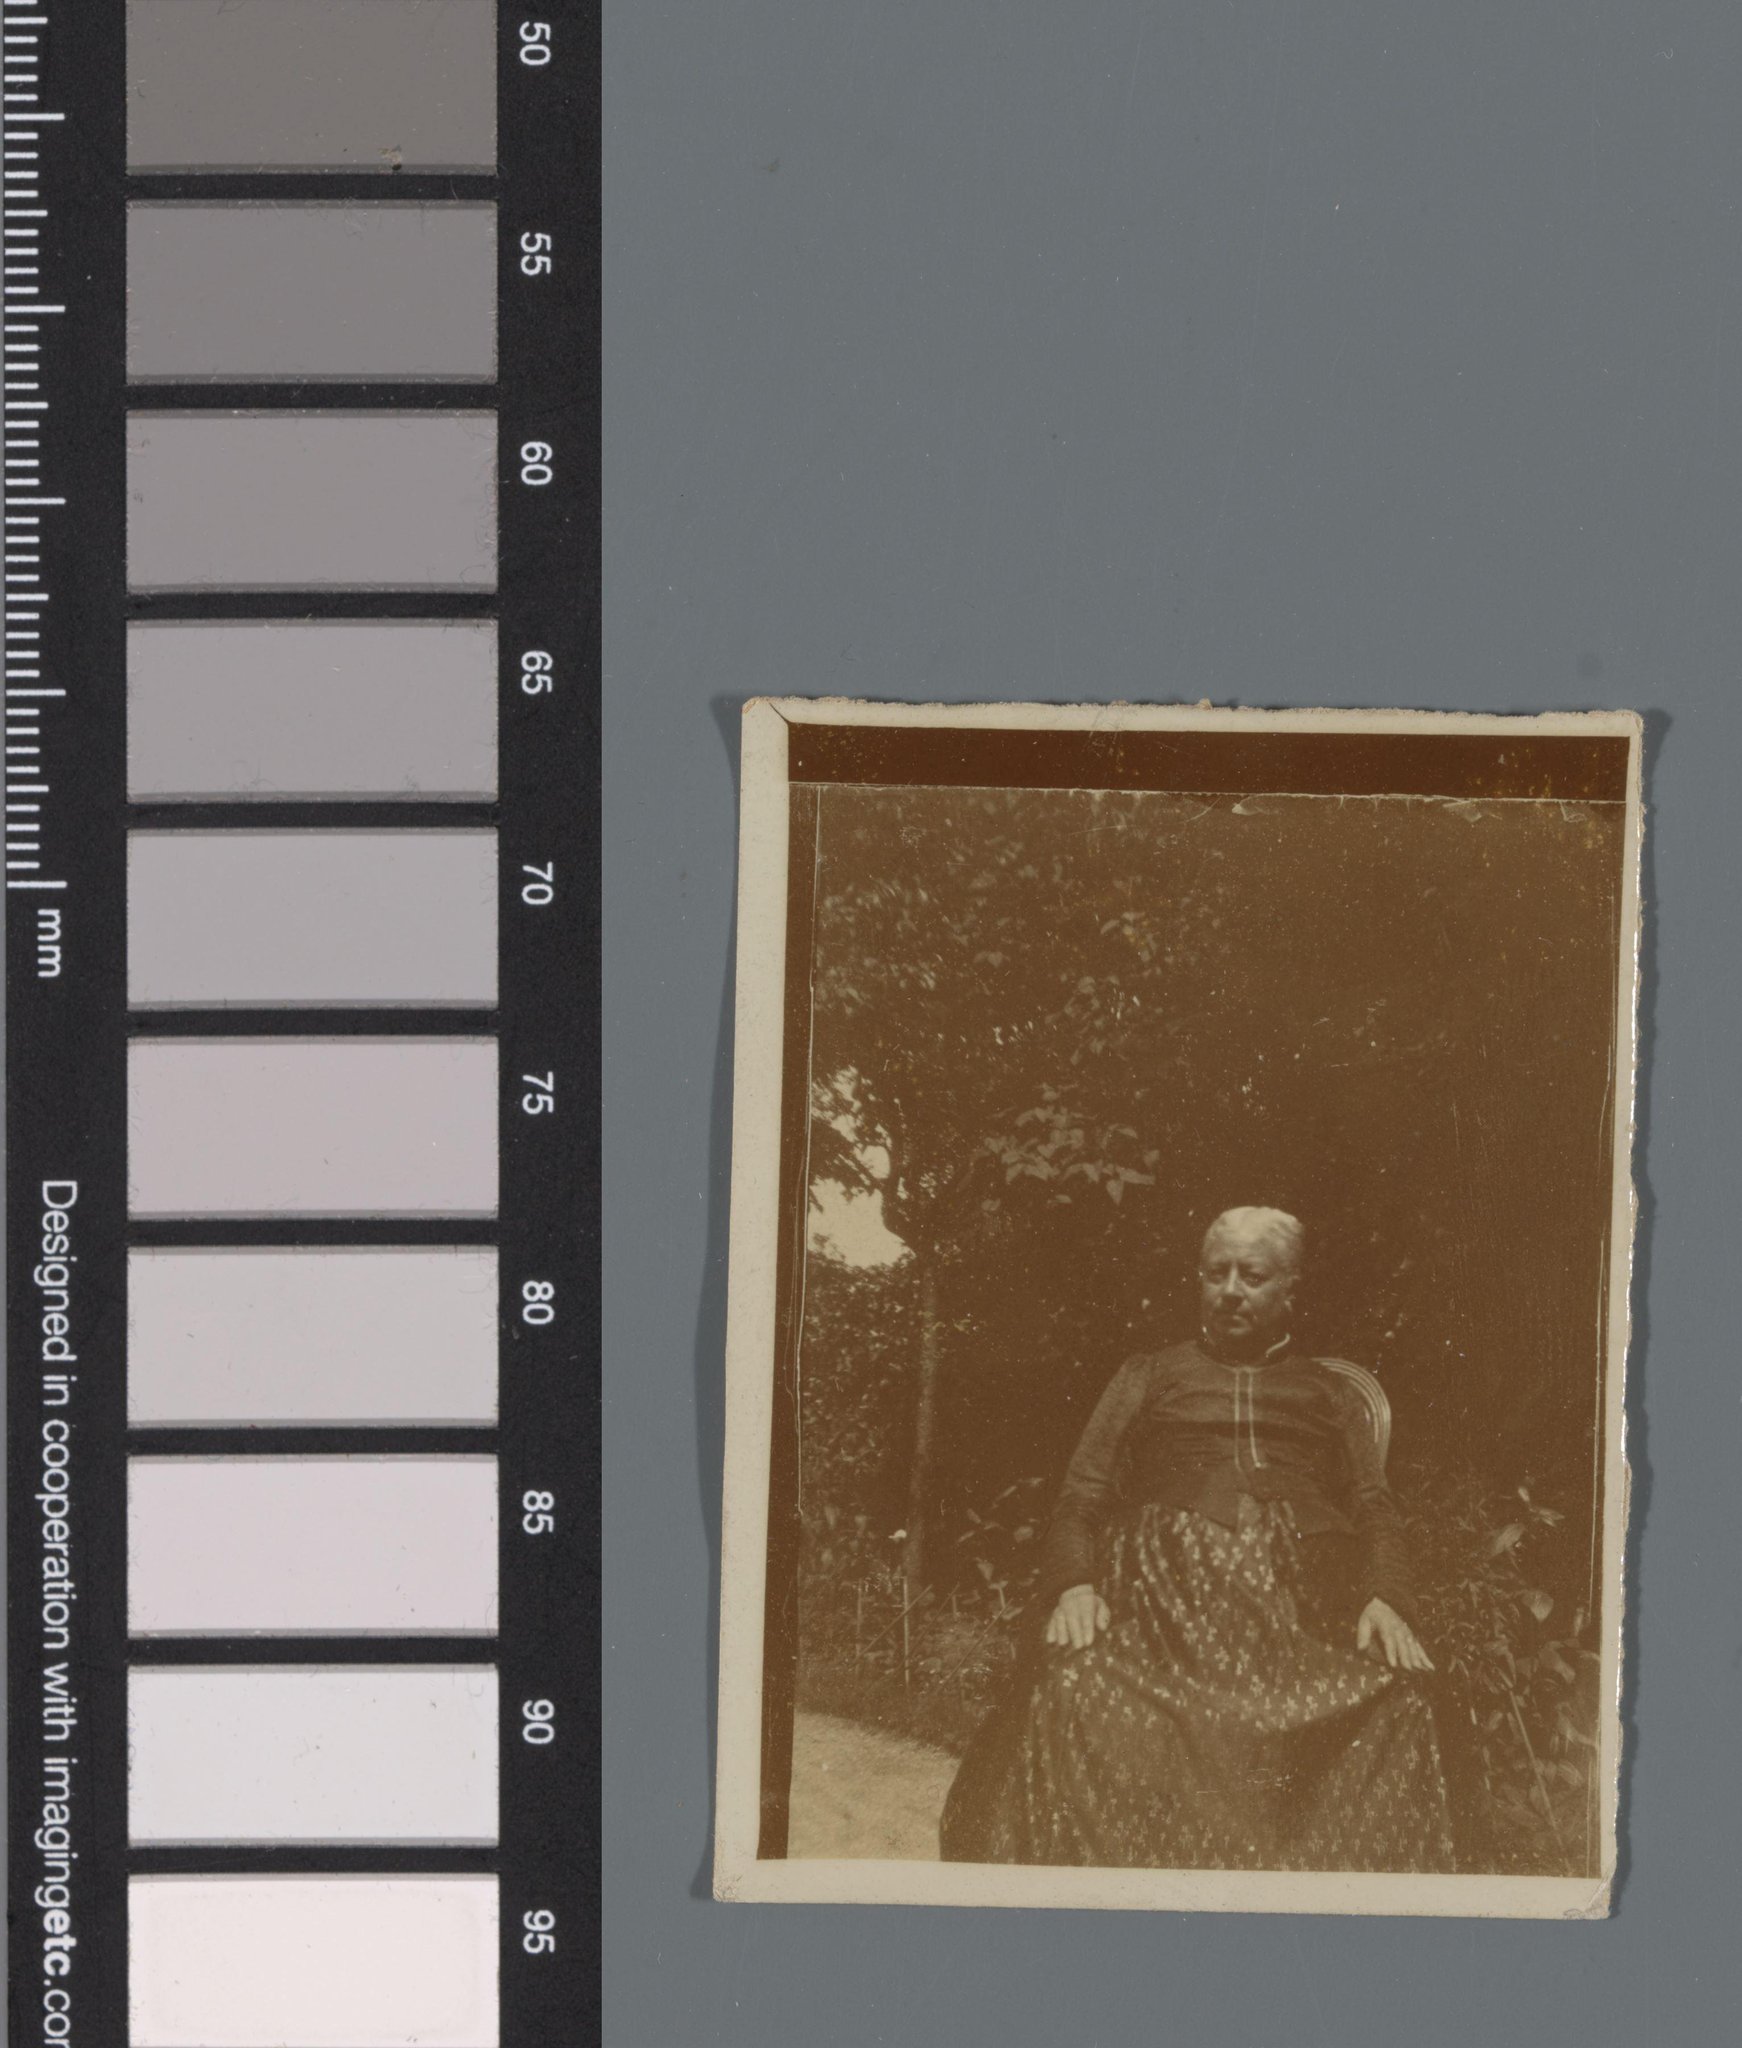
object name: photograph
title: Portret van een onbekende vrouw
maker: cornelia hendrika jonker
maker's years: 1874-1924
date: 1880-1940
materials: photographic support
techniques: collodion silver print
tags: historical persons - bb - woman